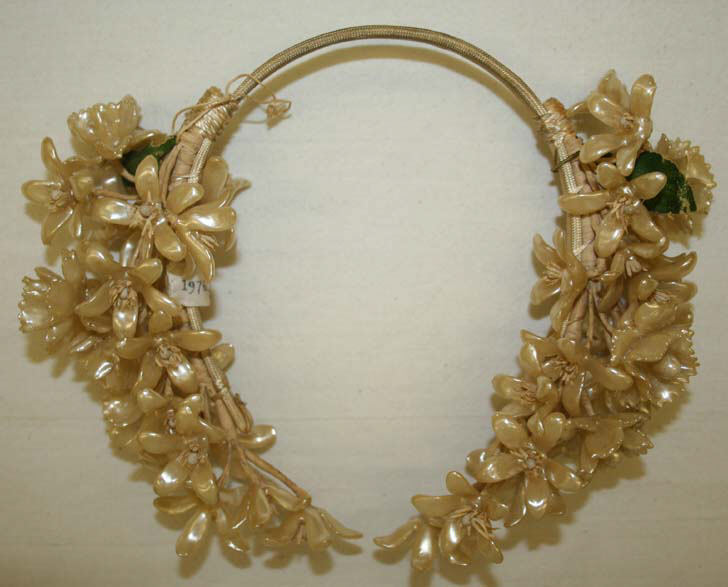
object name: wedding headdress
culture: american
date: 1840-1849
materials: metal, plaster, silk, wax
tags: flowers